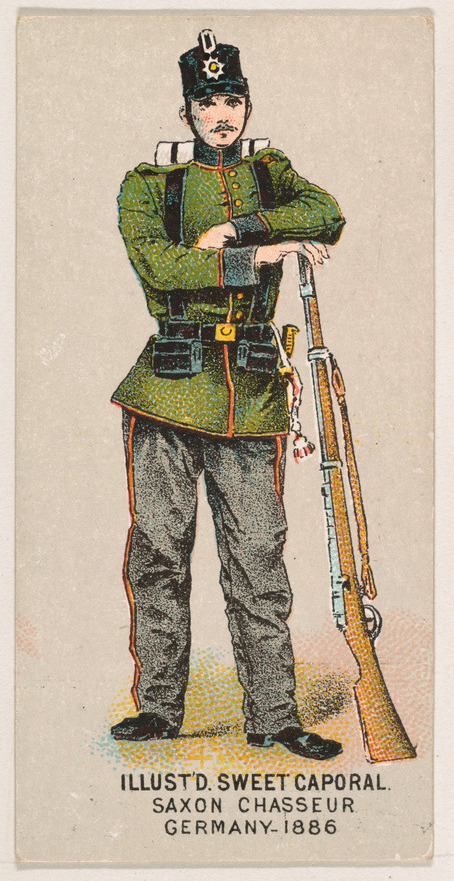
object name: print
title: Saxon Chasseur, Germany, 1886, from the Military Series (N224) issued by Kinney Tobacco Company to promote Sweet Caporal Cigarettes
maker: kinney brothers tobacco company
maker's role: publisher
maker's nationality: american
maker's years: 1869-2011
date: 1888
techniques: color lithograph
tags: military,men